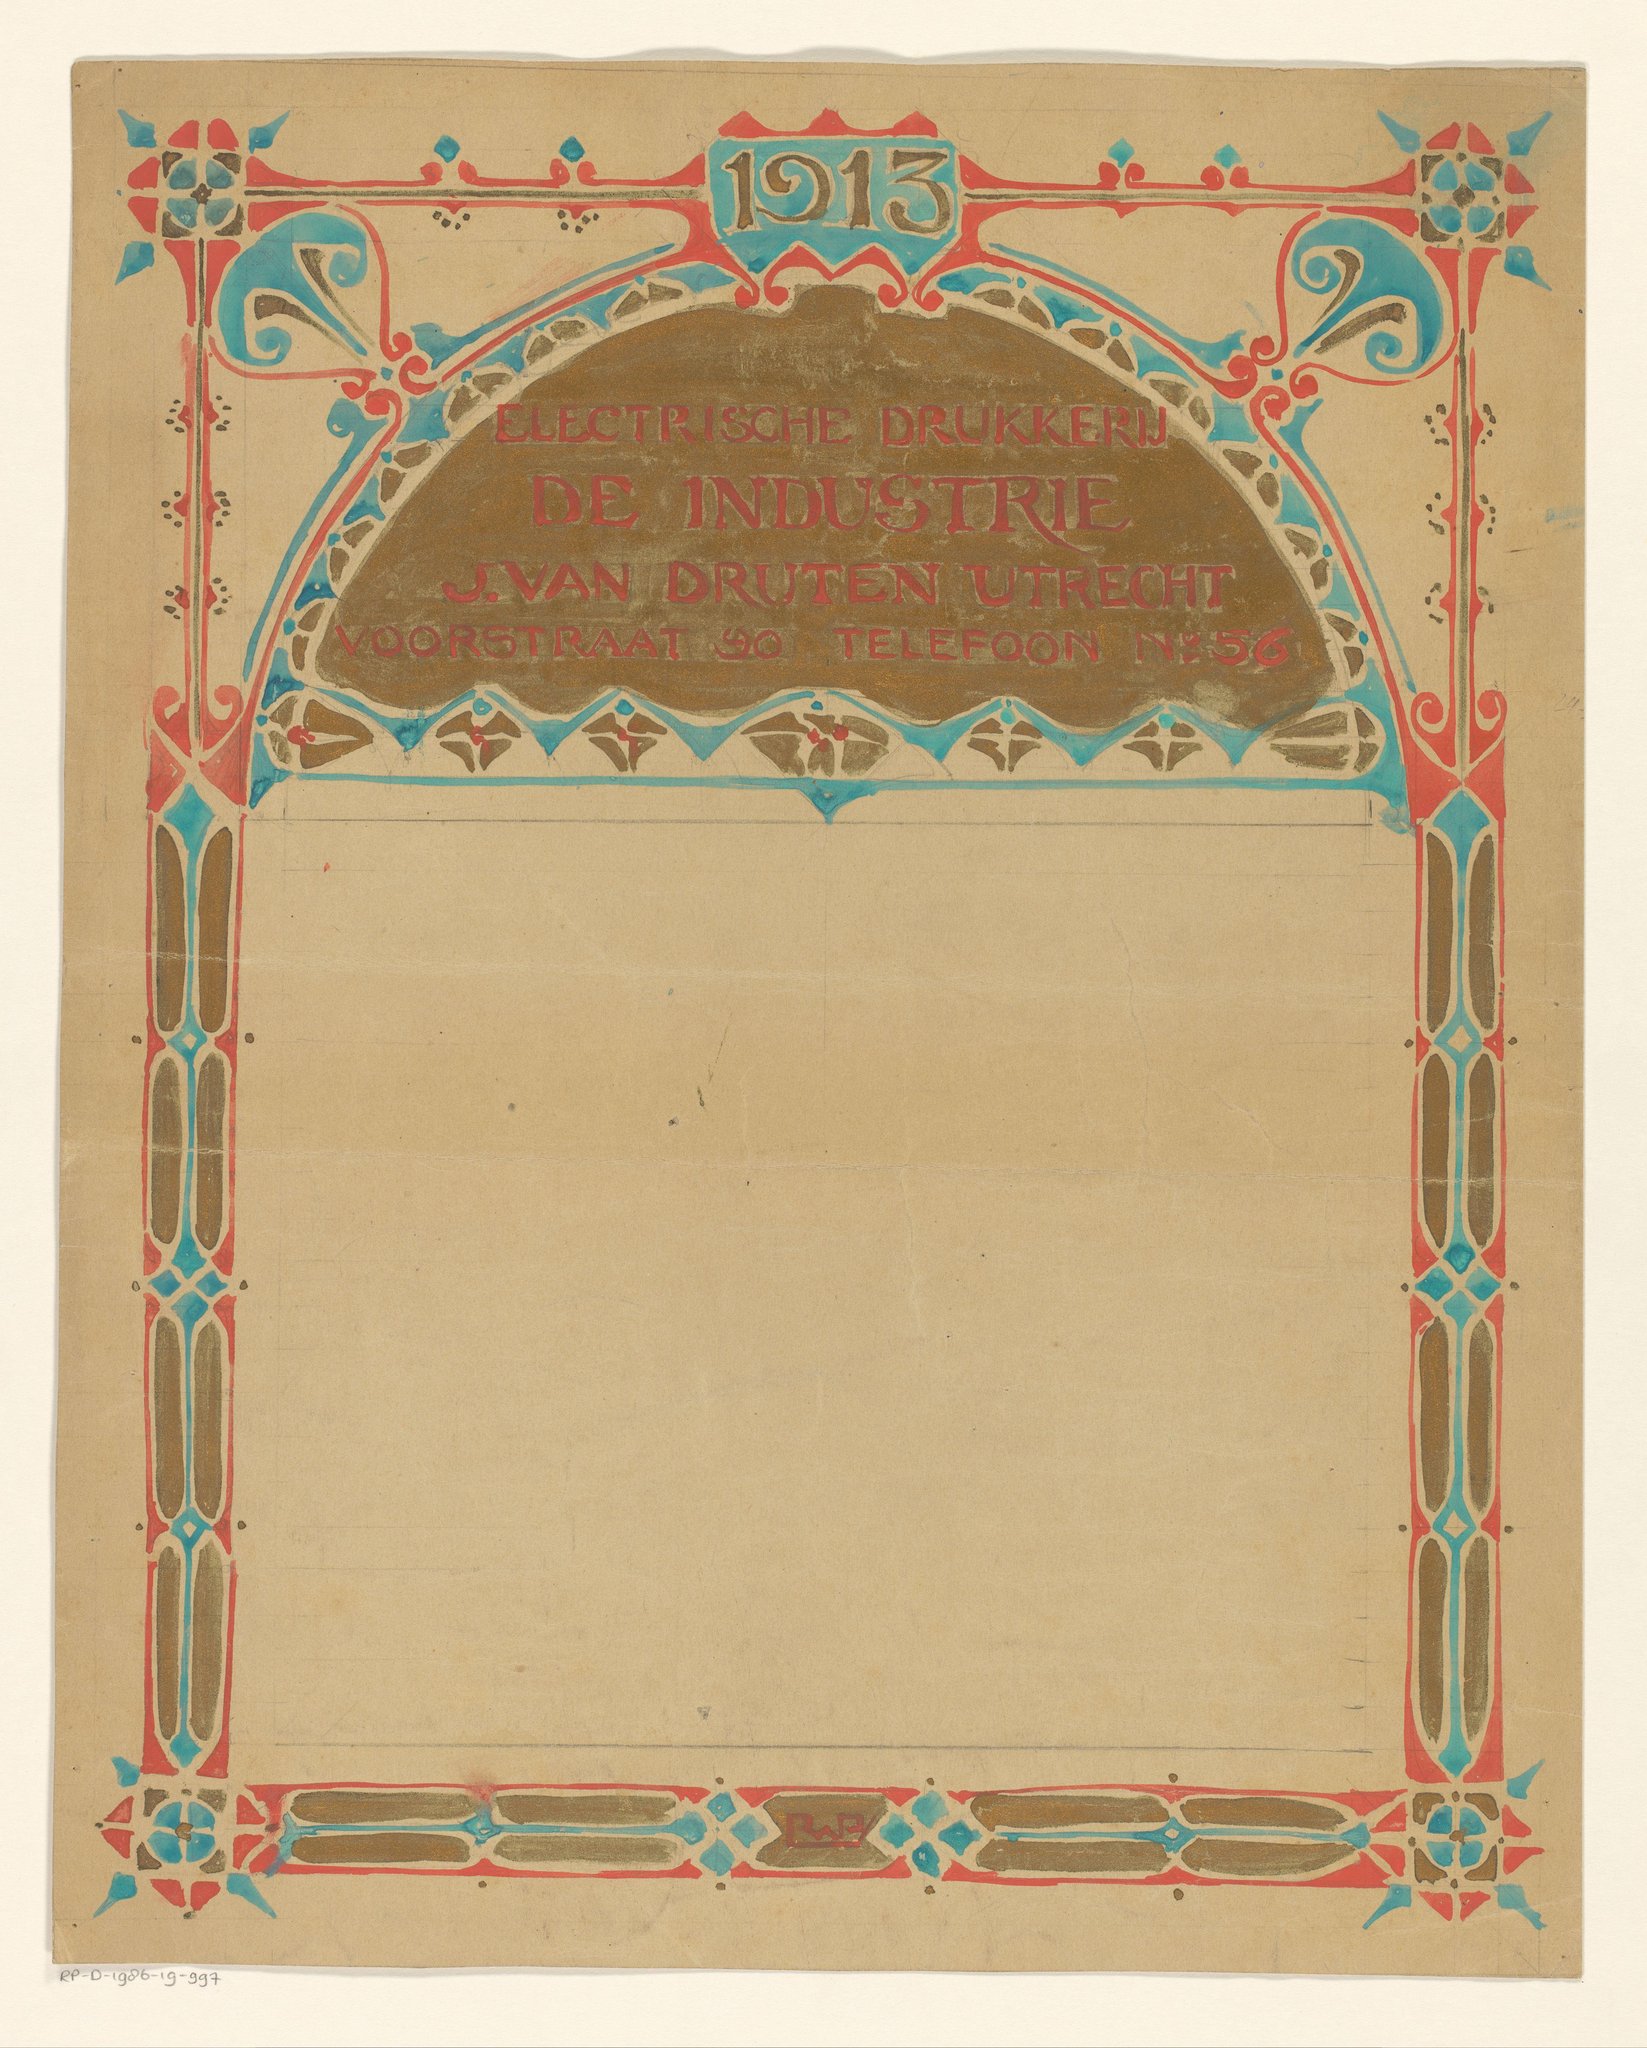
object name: design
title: Ontwerp voor een advertentie van Electrische Drukkerij De Industrie te Utrecht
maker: reinier willem petrus de vries (1874-1953)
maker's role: draughtsman, print maker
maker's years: 1874-1953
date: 1913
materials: paint, paper, pencil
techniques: brush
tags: ornaments ~ art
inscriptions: collector's mark: ‘R:MVS.’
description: Geornamenteerd kader met bovenaan de contactgegevens van de drukkerij en het jaartal '1913'.